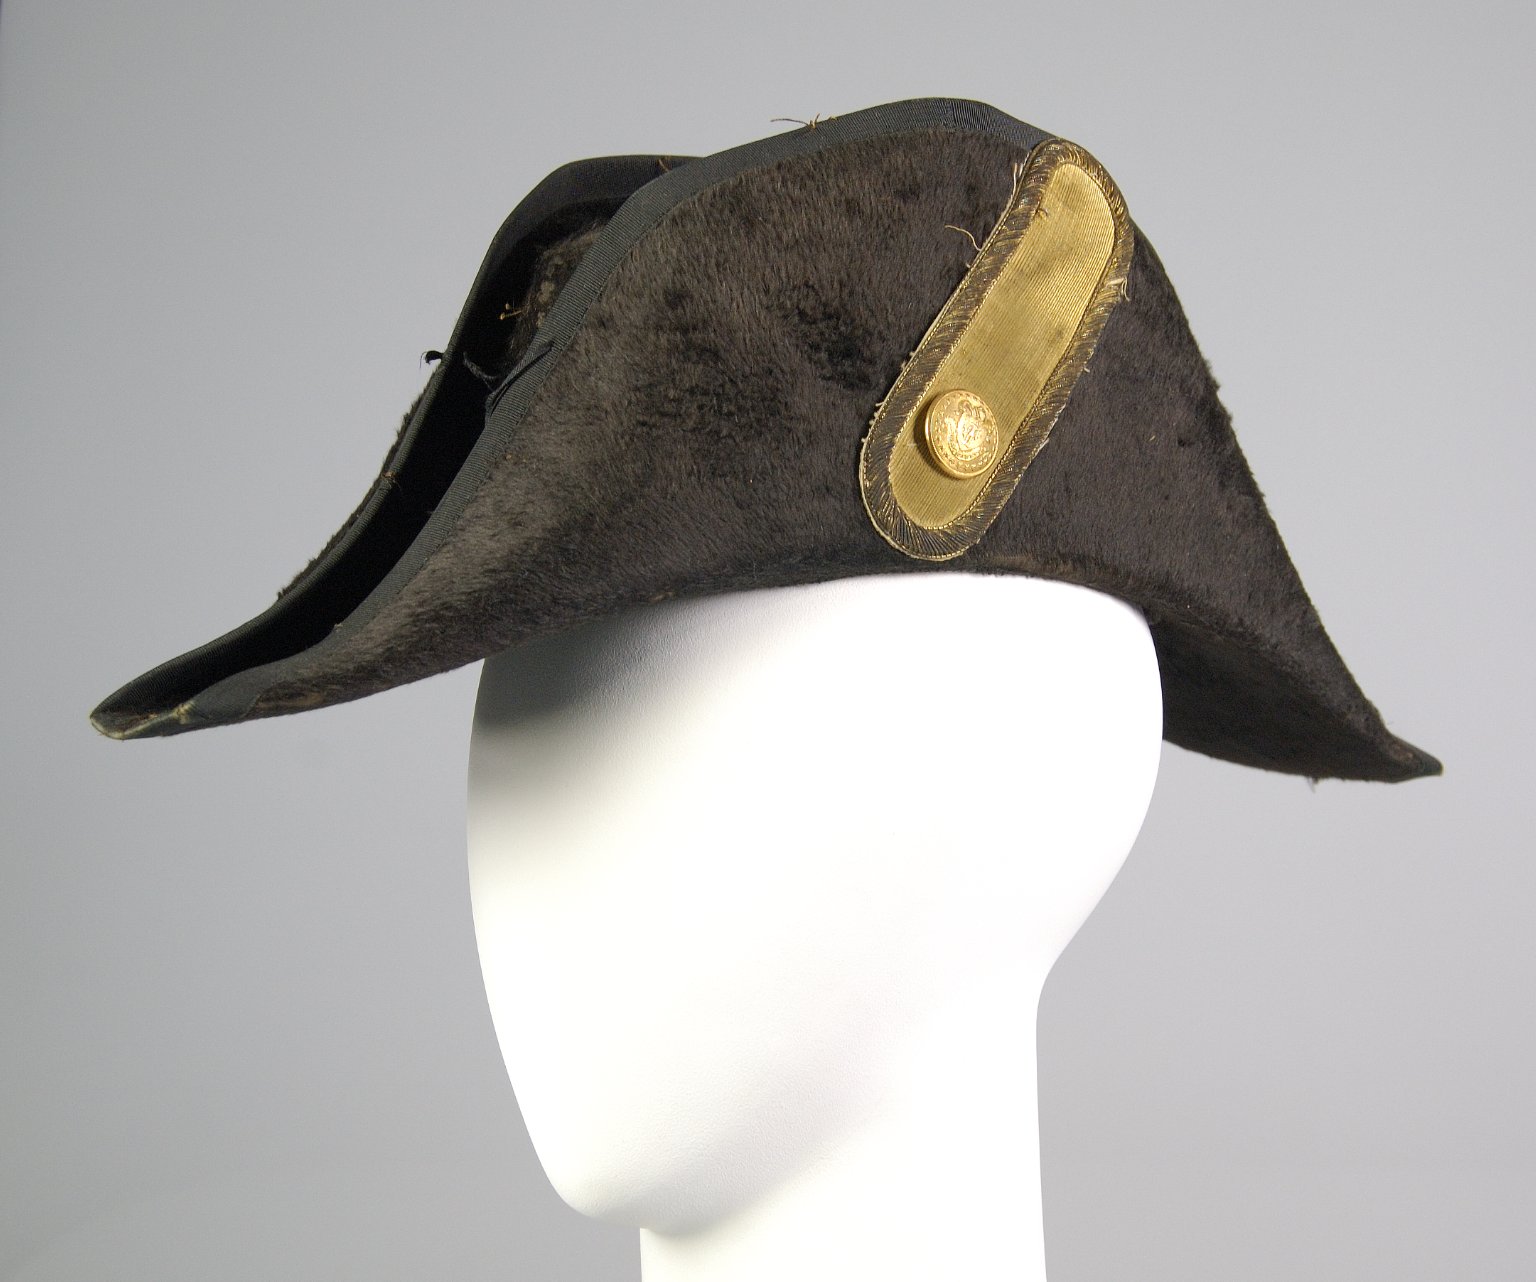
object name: military bicorne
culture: american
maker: bent & bush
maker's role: designer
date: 1875-1880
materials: fur, metal, silk